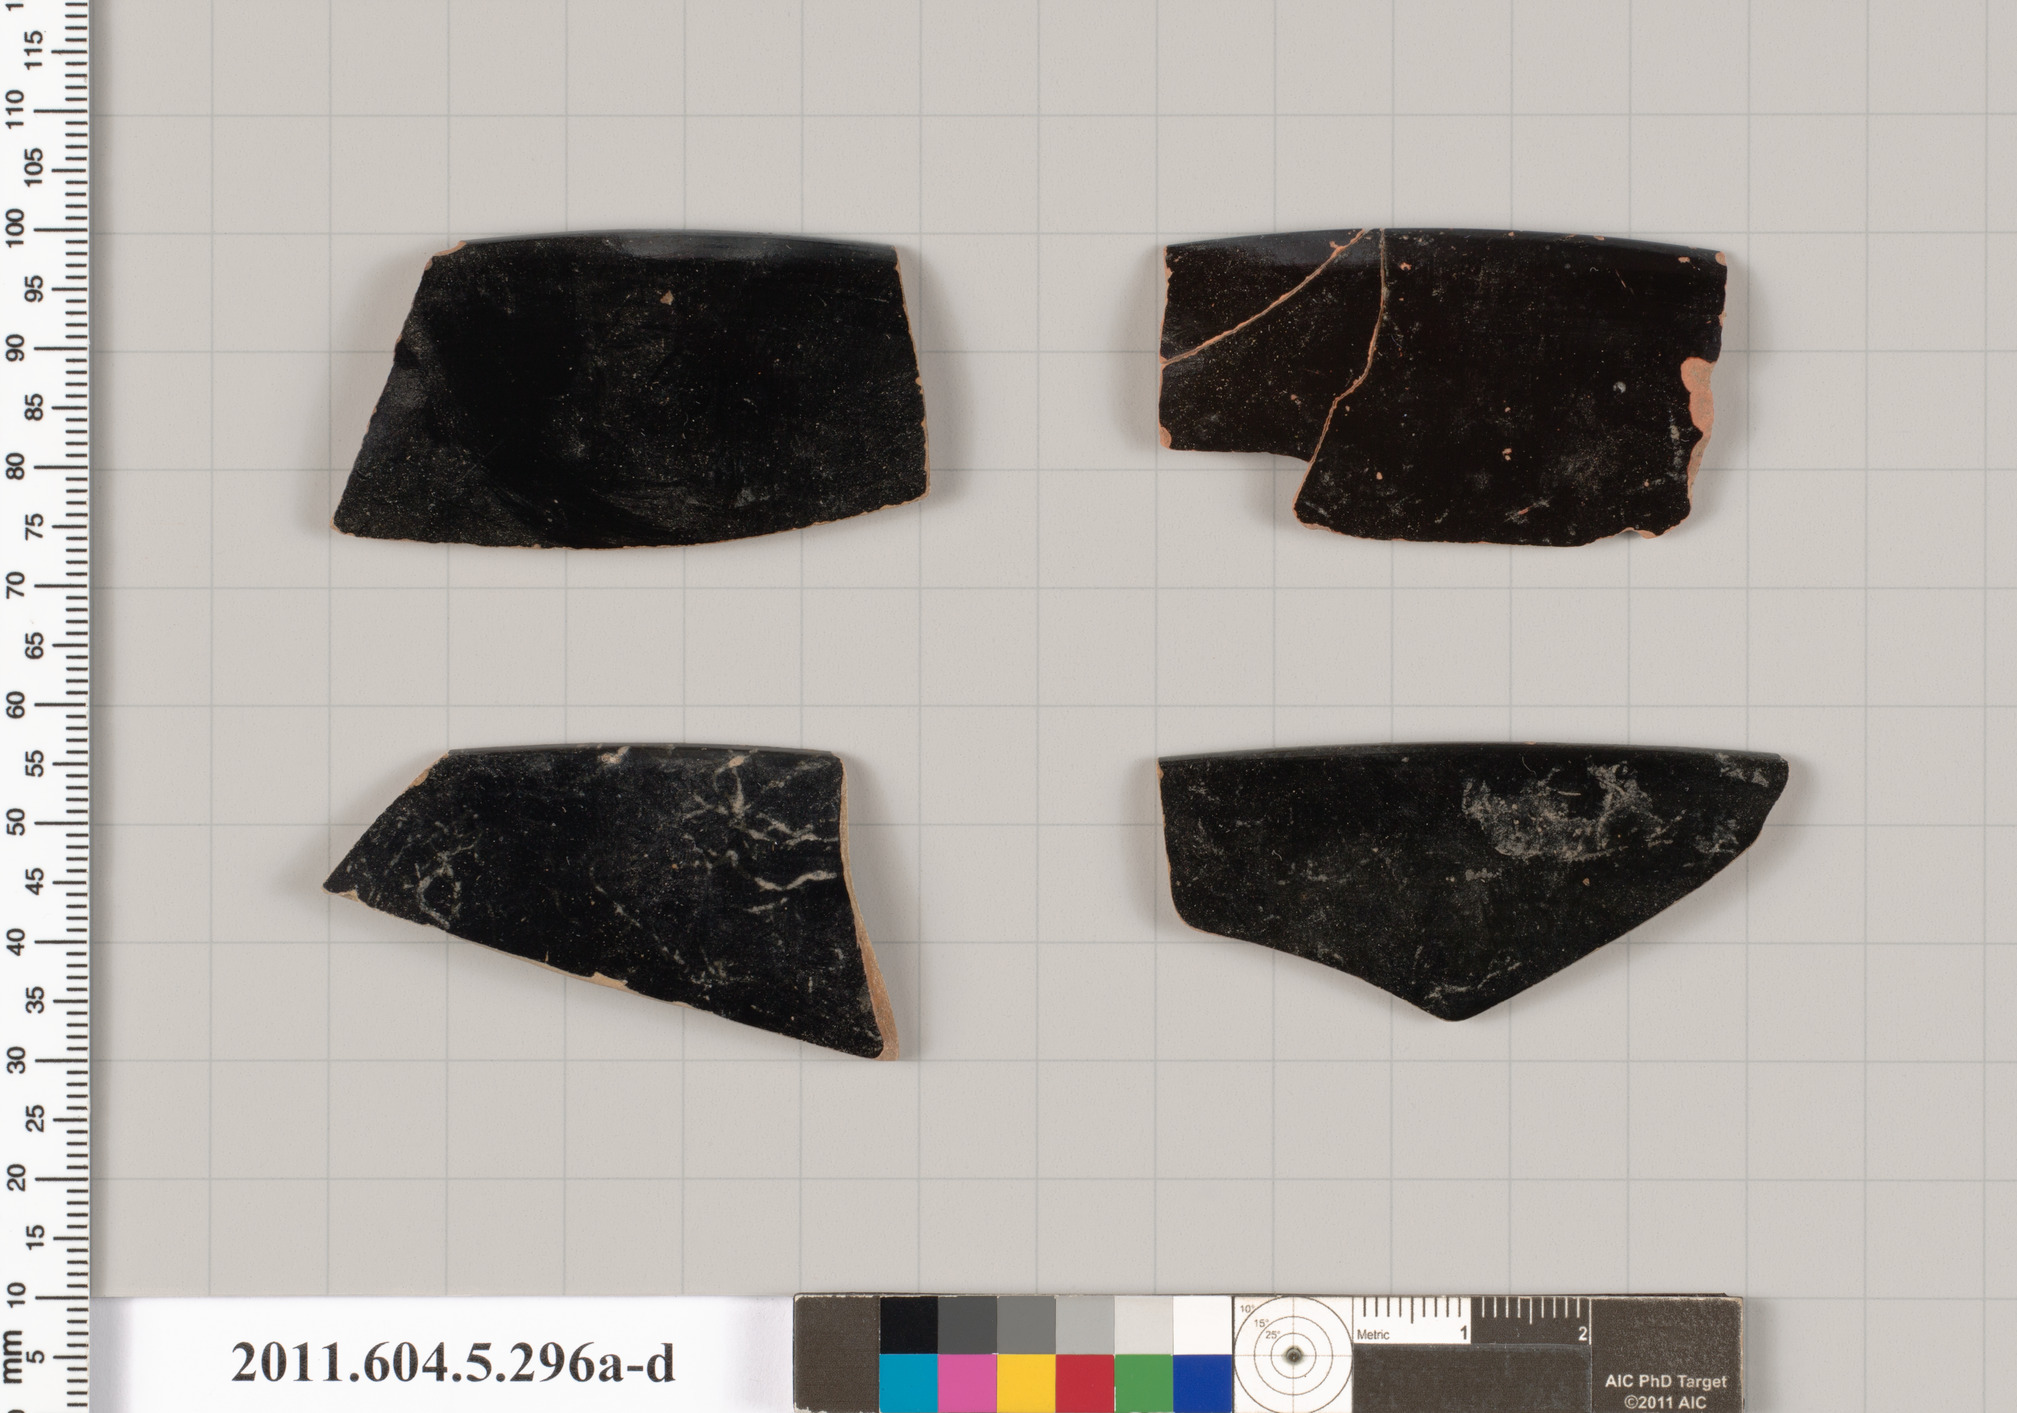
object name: kylix fragment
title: Terracotta rim fragments of kylikes (drinking cups)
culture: greek, attic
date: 600-401 BCE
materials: terracotta